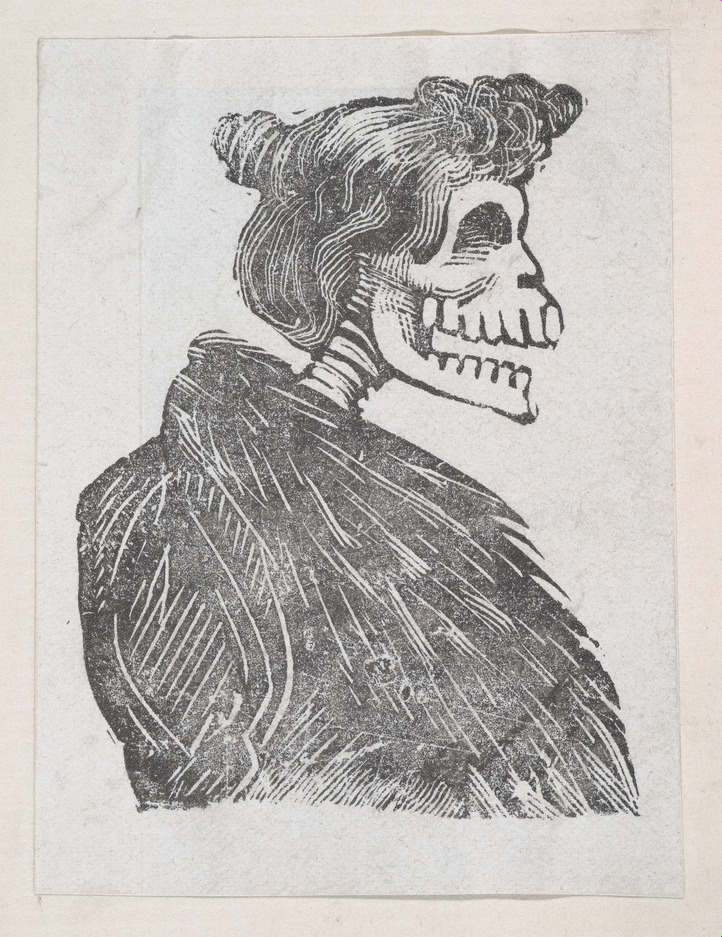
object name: print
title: Profile of a female skeleton with a fur vest, from a broaside entitled 'La Calavera de Cupido', published by Antonio Vanegas Arroyo.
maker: josé guadalupe posada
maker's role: artist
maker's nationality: mexican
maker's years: 1852-1913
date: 1892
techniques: lithography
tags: skeletons,women